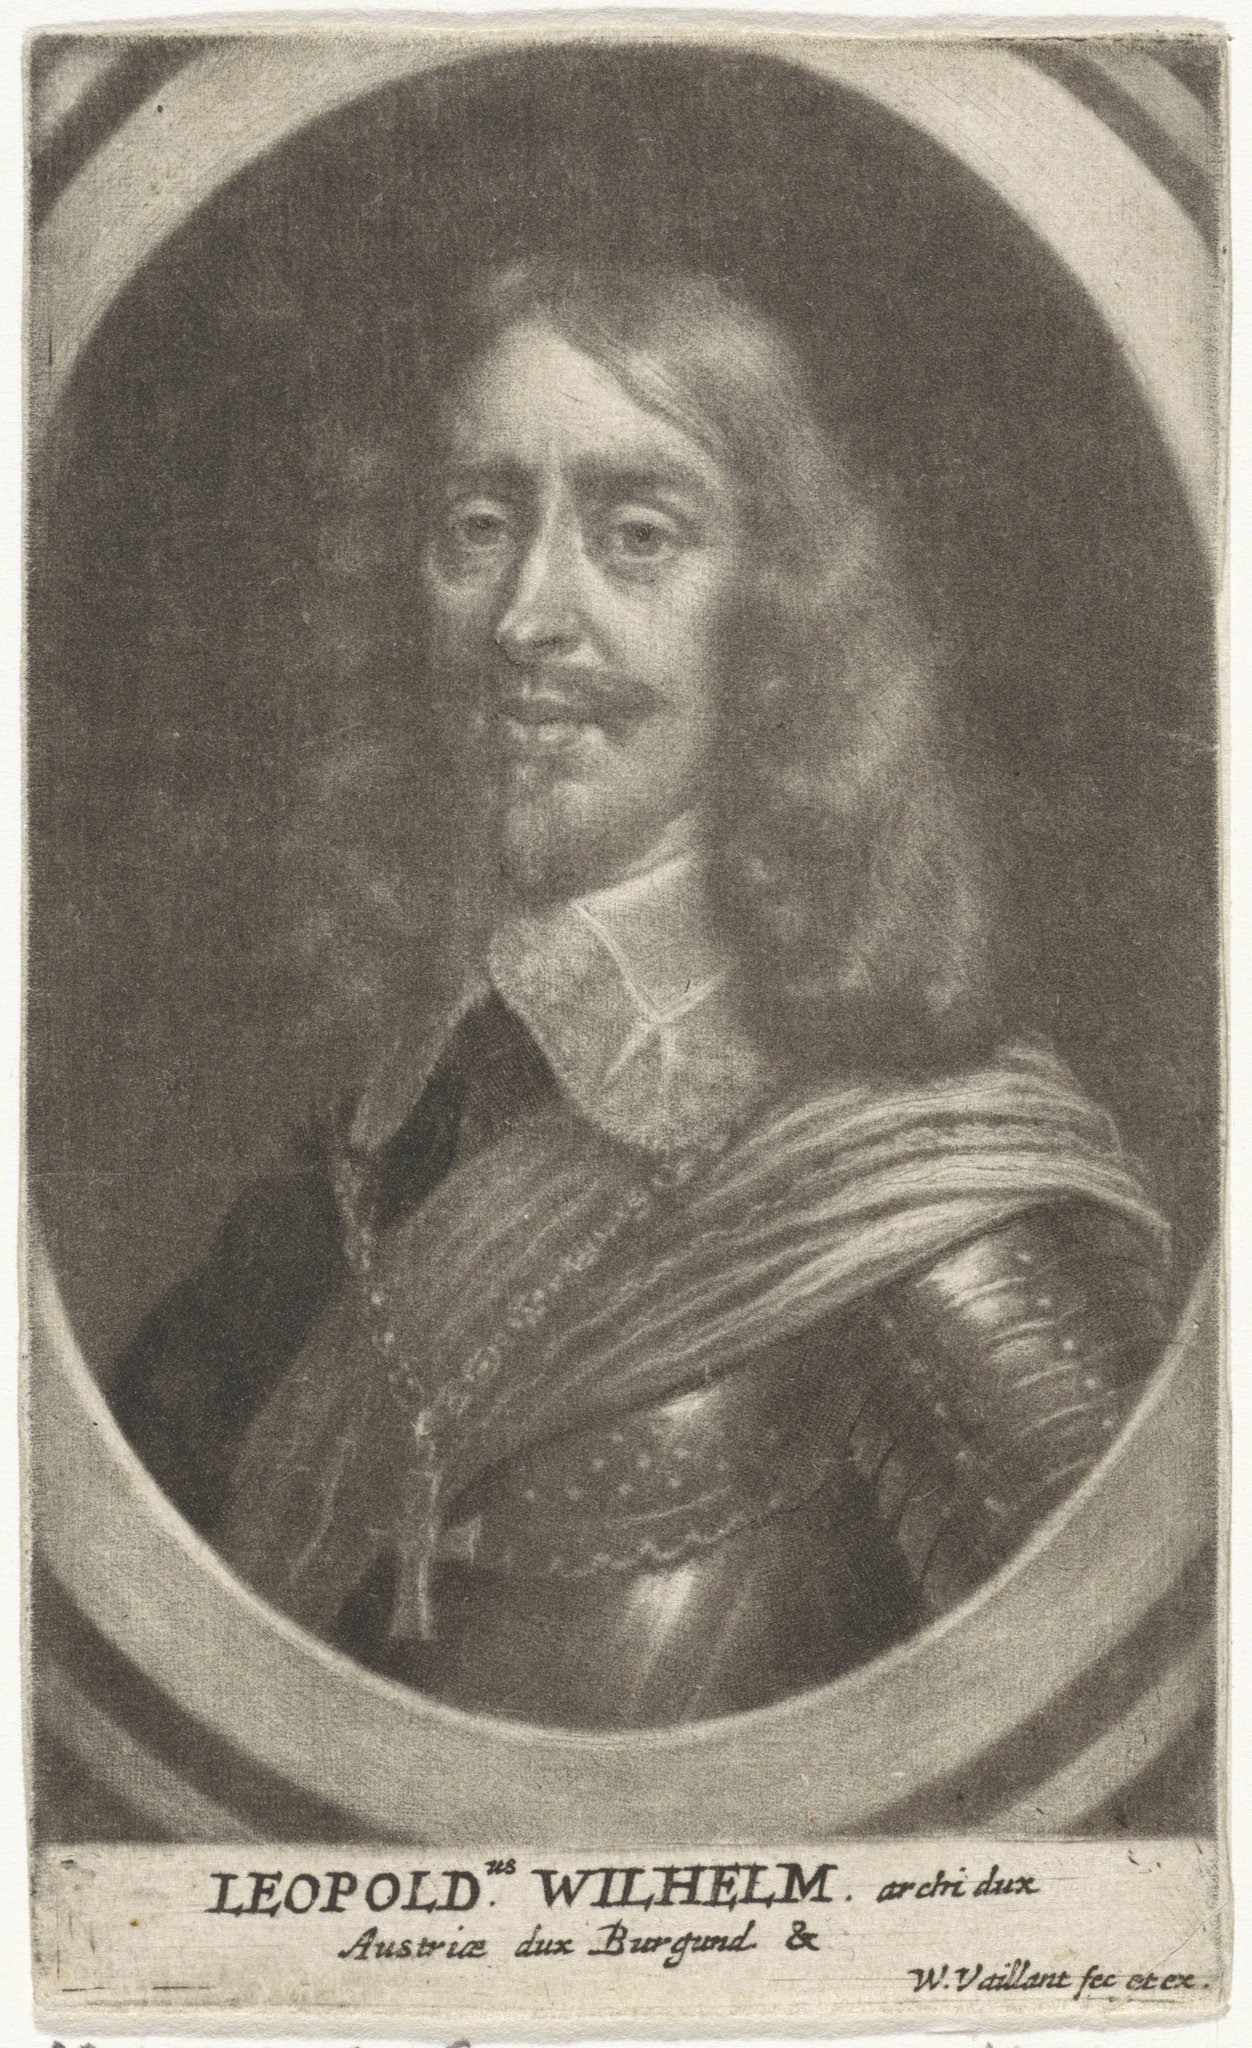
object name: print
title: Portret van Leopold Willem van Oostenrijk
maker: wallerant vaillant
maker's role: draughtsman, painter, print maker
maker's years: 1623-1677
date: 1658-1677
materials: paper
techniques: mezzotint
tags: vienna, leopold willem van oostenrijk (landvoogd der zuidelijke nederlanden)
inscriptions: collector's mark: Lugt 2228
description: Leopold Willem, aartshertog van Oostenrijk en landvoogd van de Zuidelijke Nederlanden.